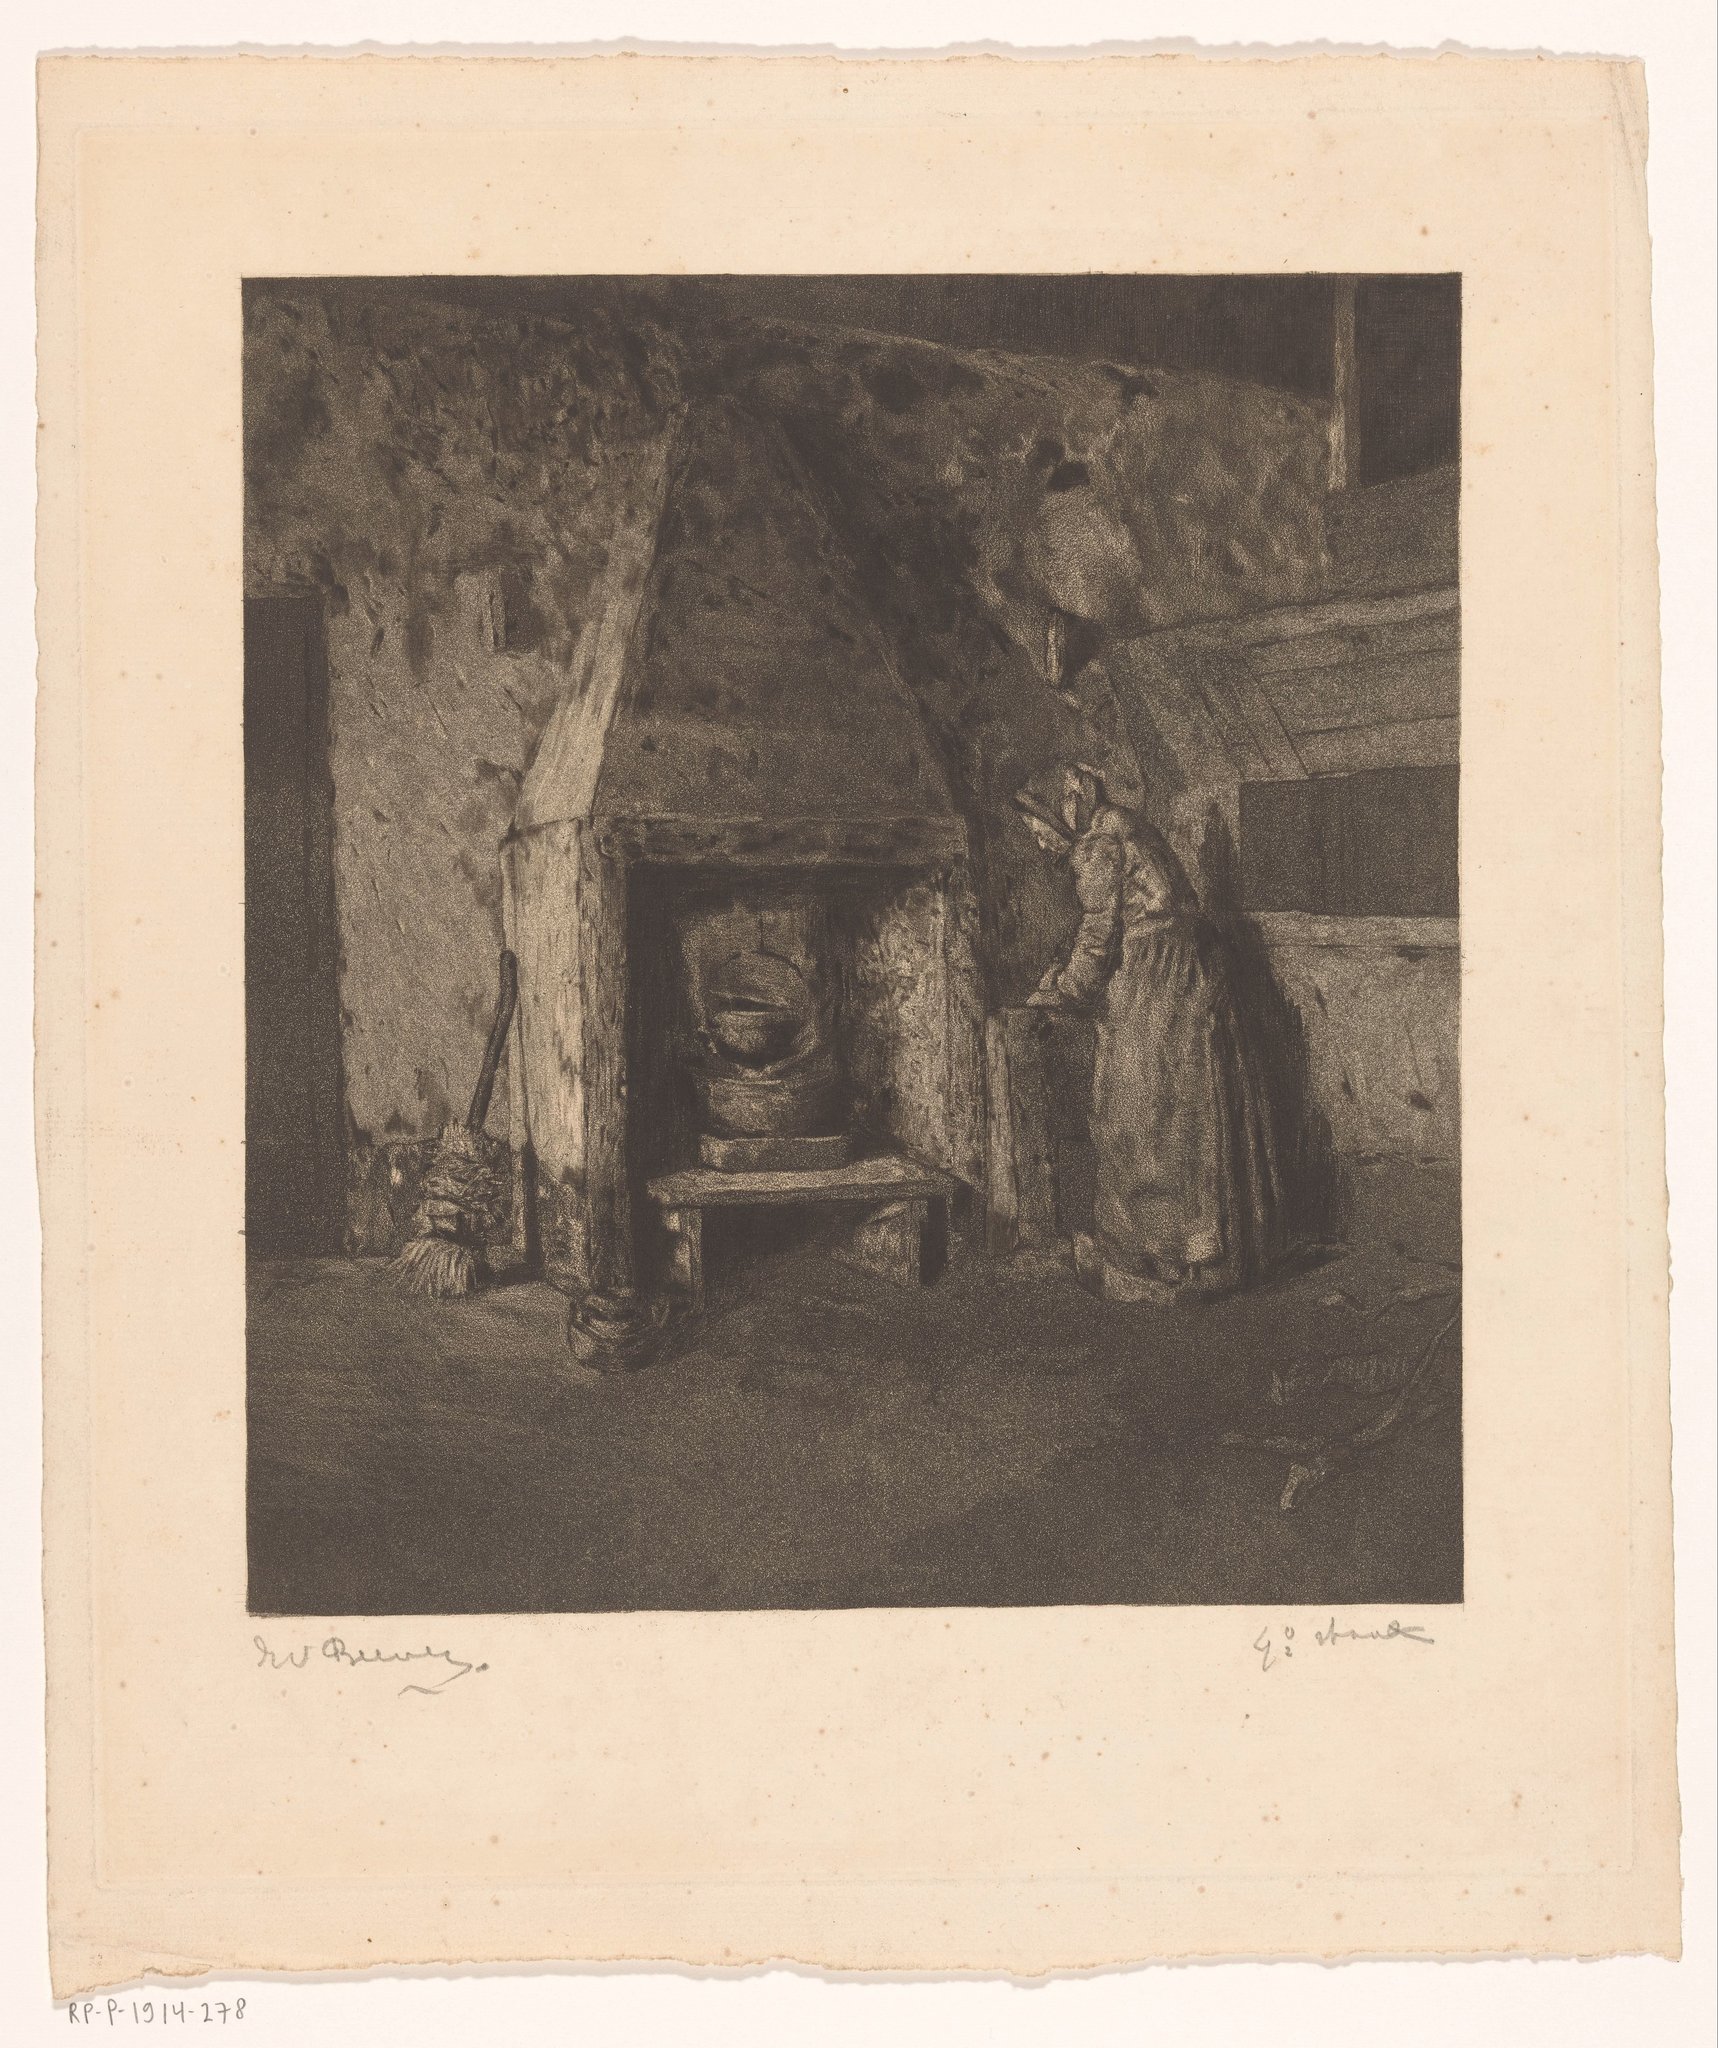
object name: print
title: Boerenvrouw staand bij een haard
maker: emanuel samson van beever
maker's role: draughtsman, painter, print maker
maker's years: 1876-1912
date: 1886-1912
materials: paper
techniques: aquatint, etching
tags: open hearth, fire-place, farm (building) - aa - civic architecture: inside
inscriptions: collector's mark: Lugt 2233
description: De vrouw draagt een hoofddoek. Tegen de haard leunt een bezem.